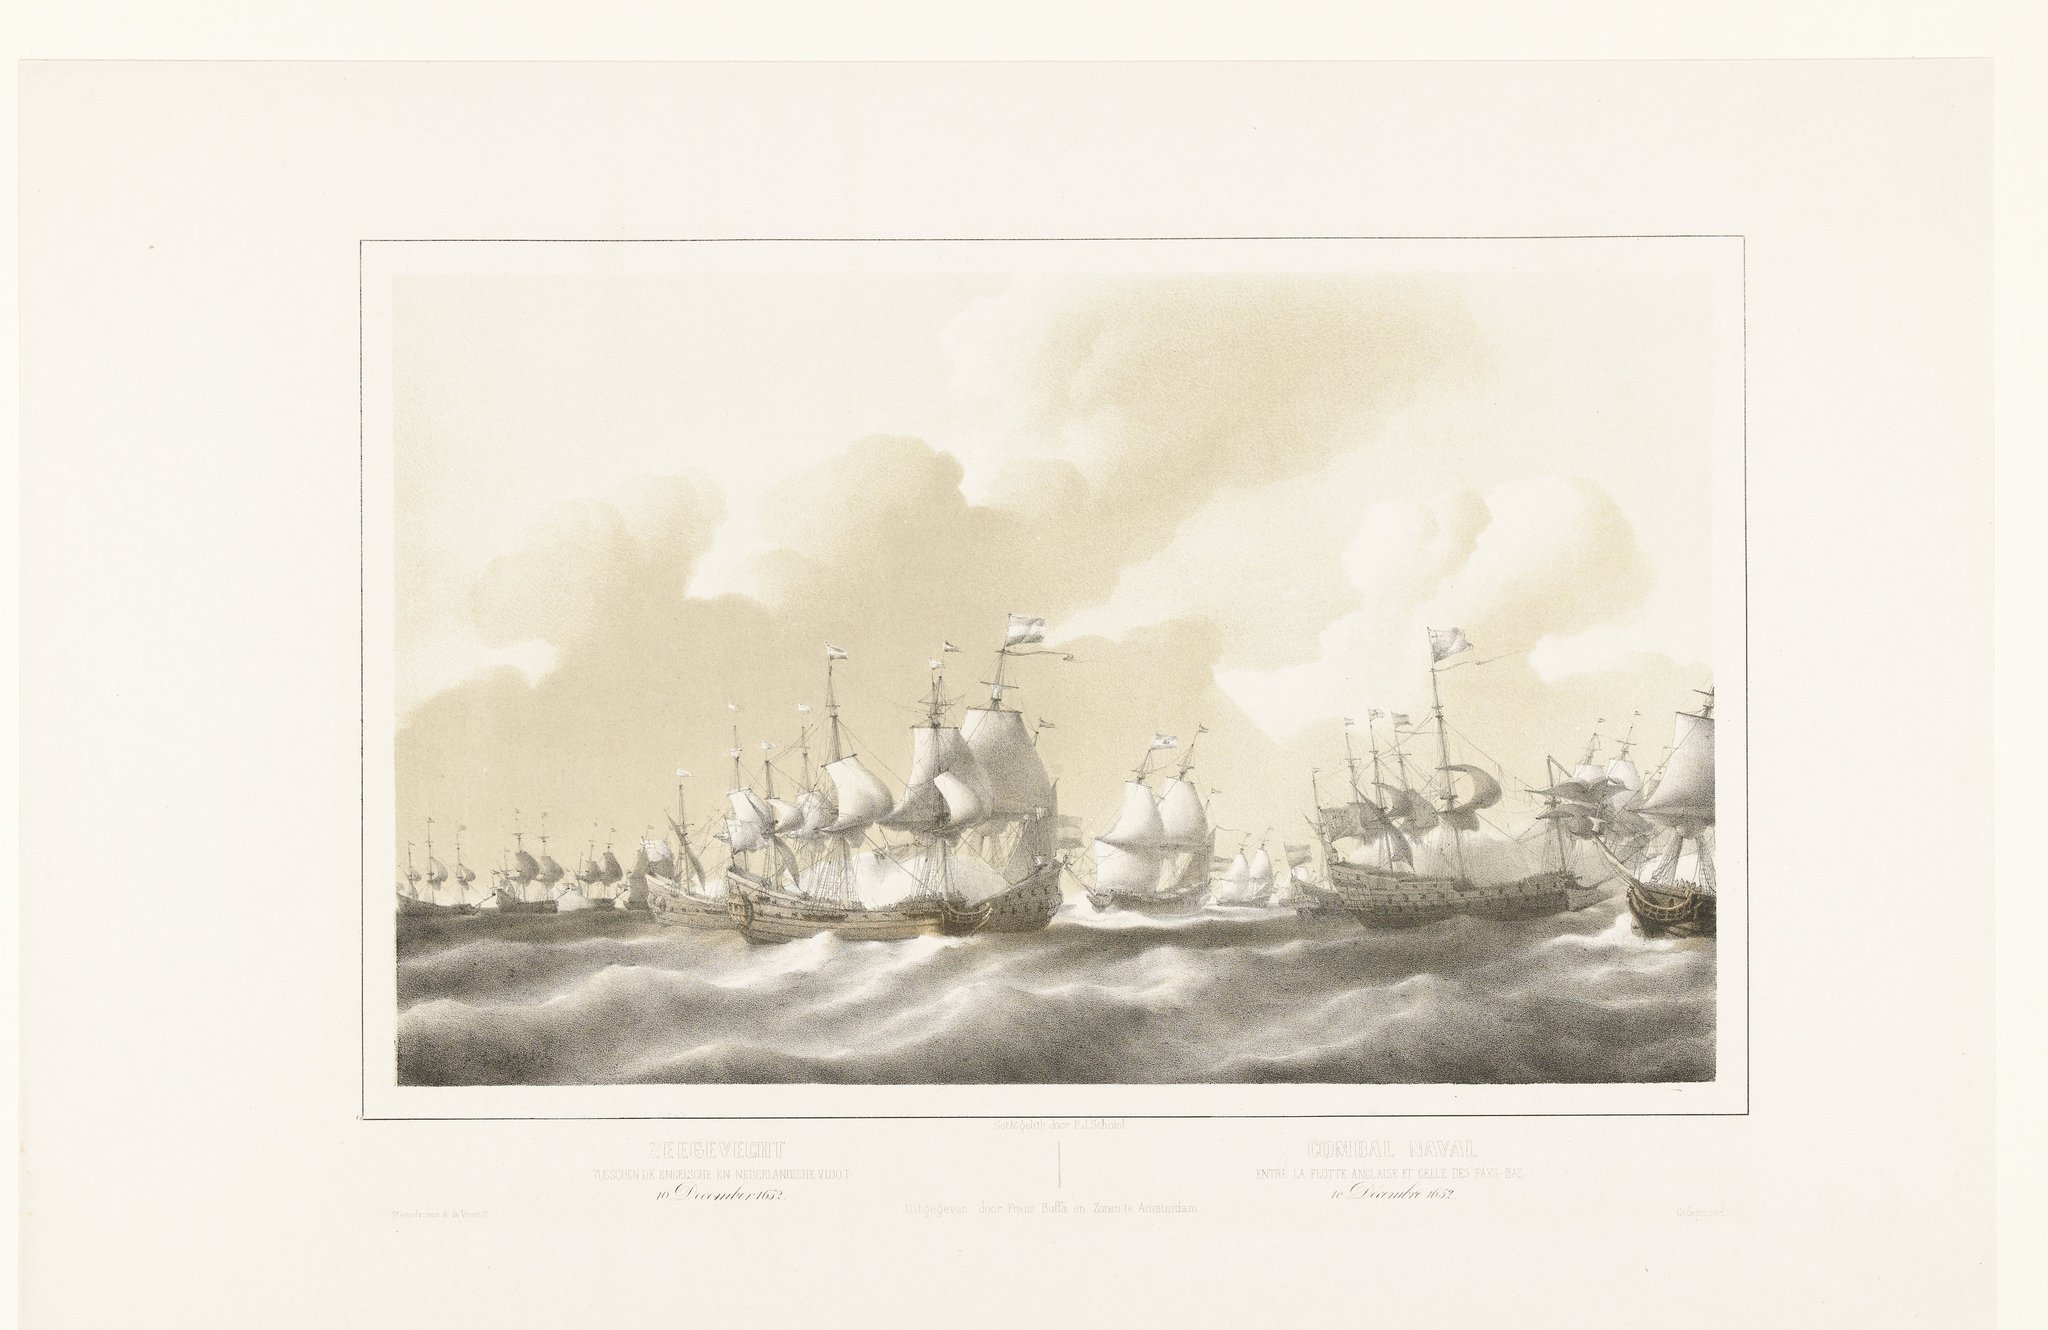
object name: print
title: Zeegevecht tusschen de Engelsche en Nederlandsche vloot 10 December 1652 / Combat naval entre la flotte Anglaise et celle des Pays-Bas 10 Décembre 1652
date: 1848-1855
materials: paper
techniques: lithograph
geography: amsterdam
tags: flushing, brielle, maarten harpertszoon tromp, battle (+ naval force), battle of dungeness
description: Zeeslag bij Dungeness (de Slag bij de Singels) voor de Engelse kust bij Dover in de Eerste Engelse Oorlog tussen de Staatse vloot onder Maarten Tromp en de Engelse vloot onder Robert Blake, 10 december 1652. Centraal het gevecht van het admiraalsschip de Brederode van Tromp in gevecht met de Engelse schepen Bonaventure en de Rozenkans. Van rechts schiet het schip van vice-admiraal Johan Evertsen te hulp.